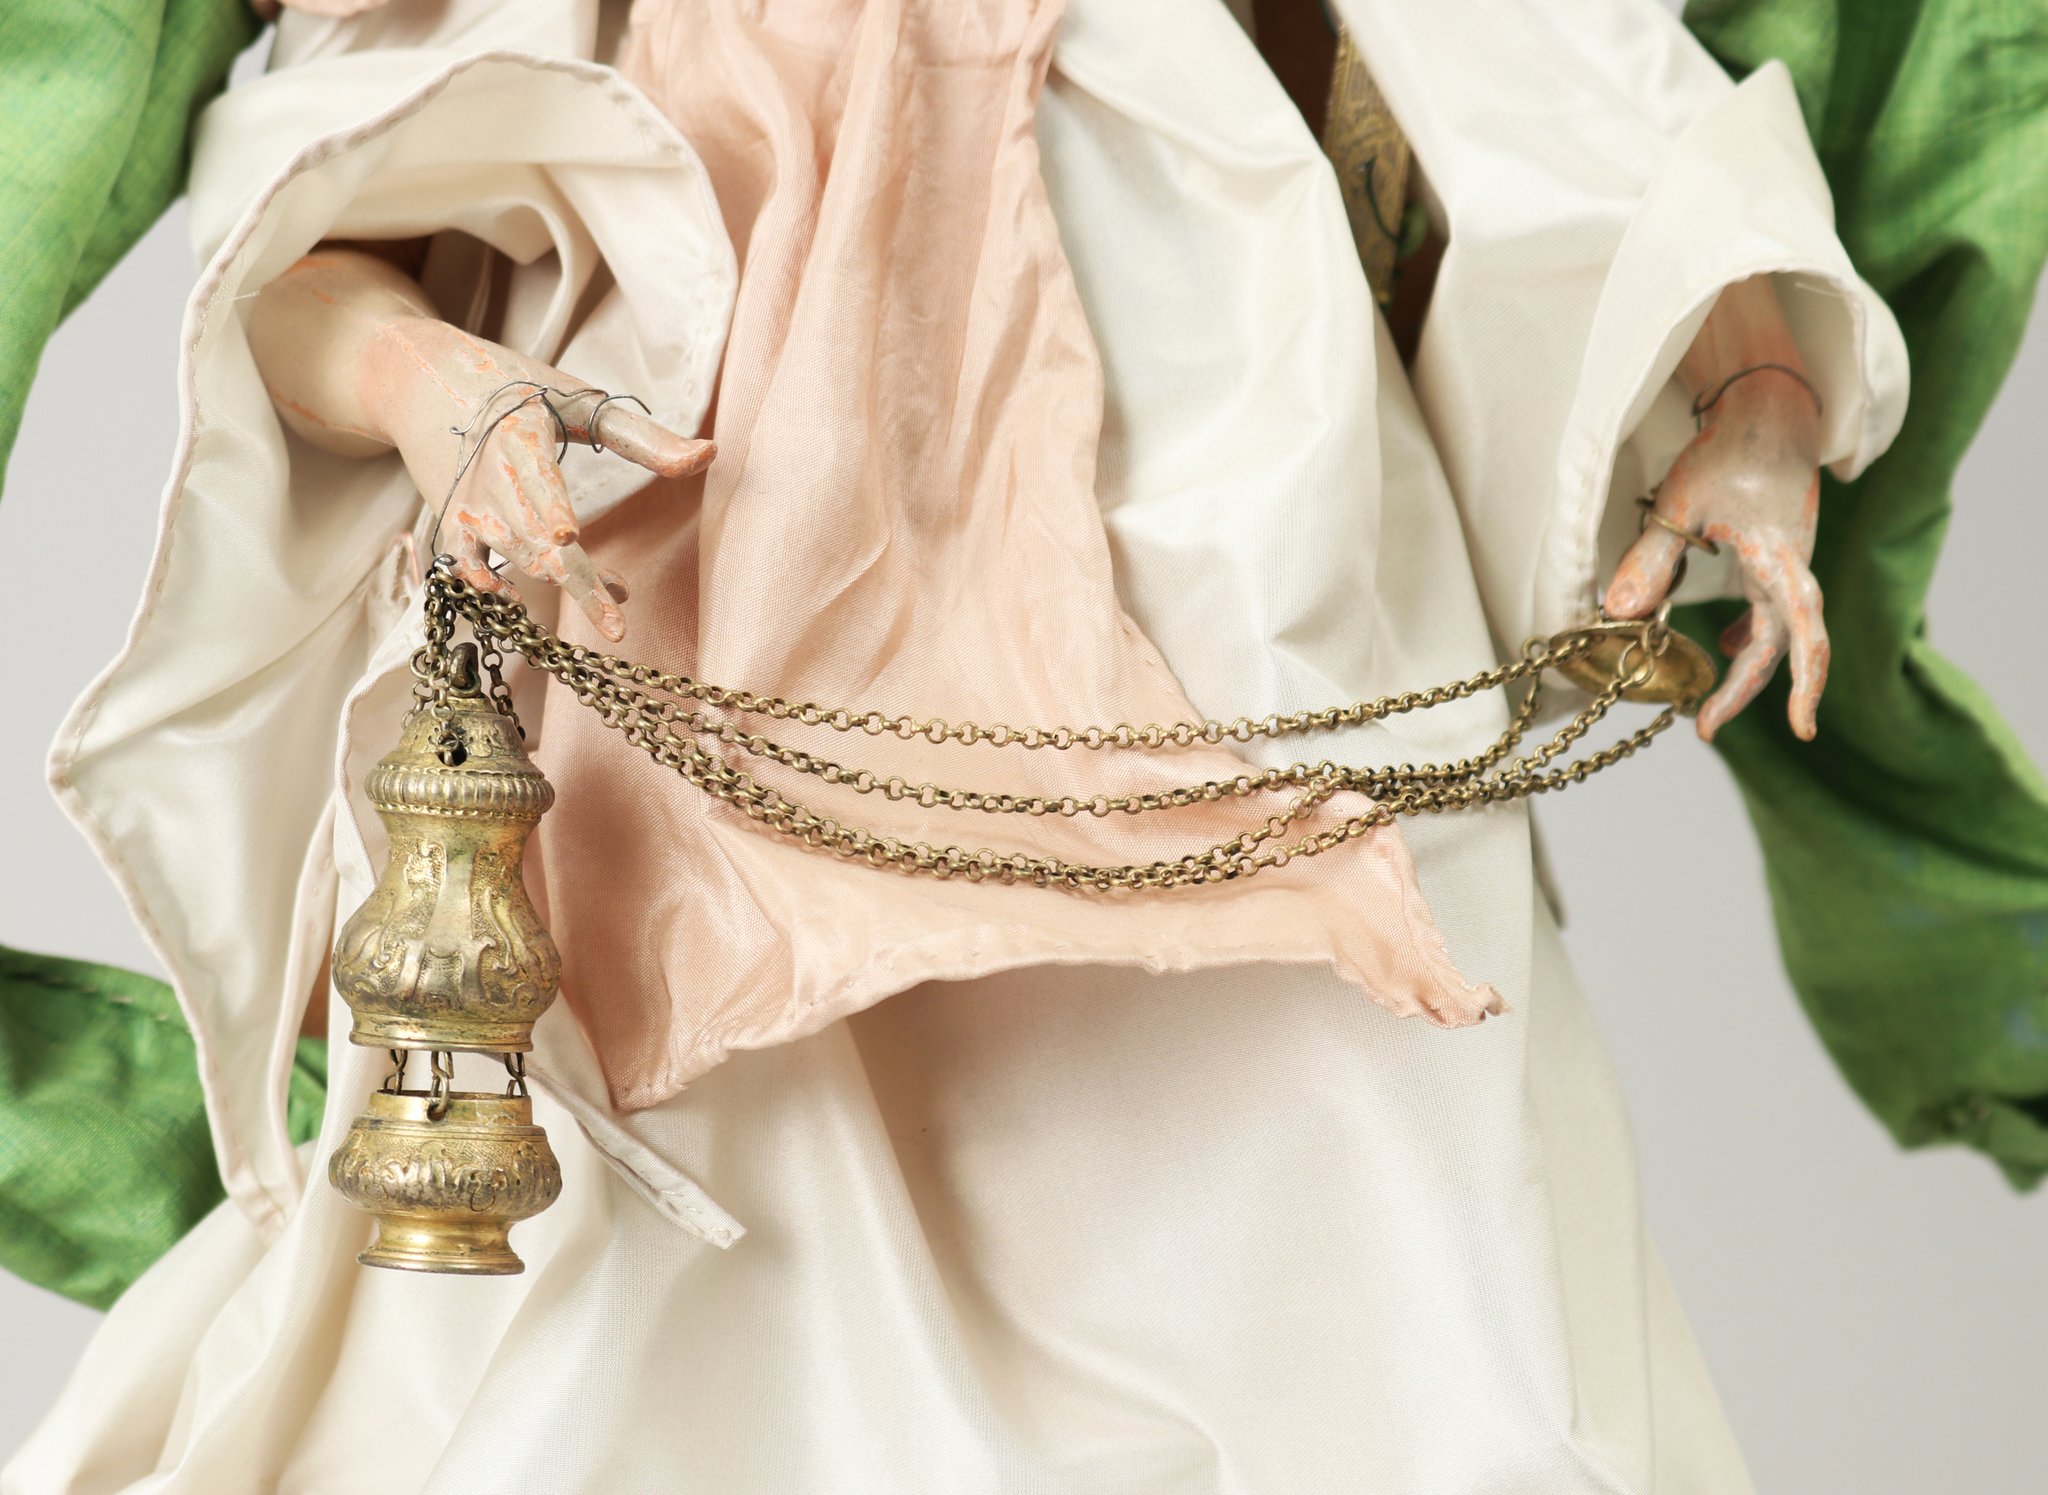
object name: crèche figure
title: Censer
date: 1751-1800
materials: silver gilt